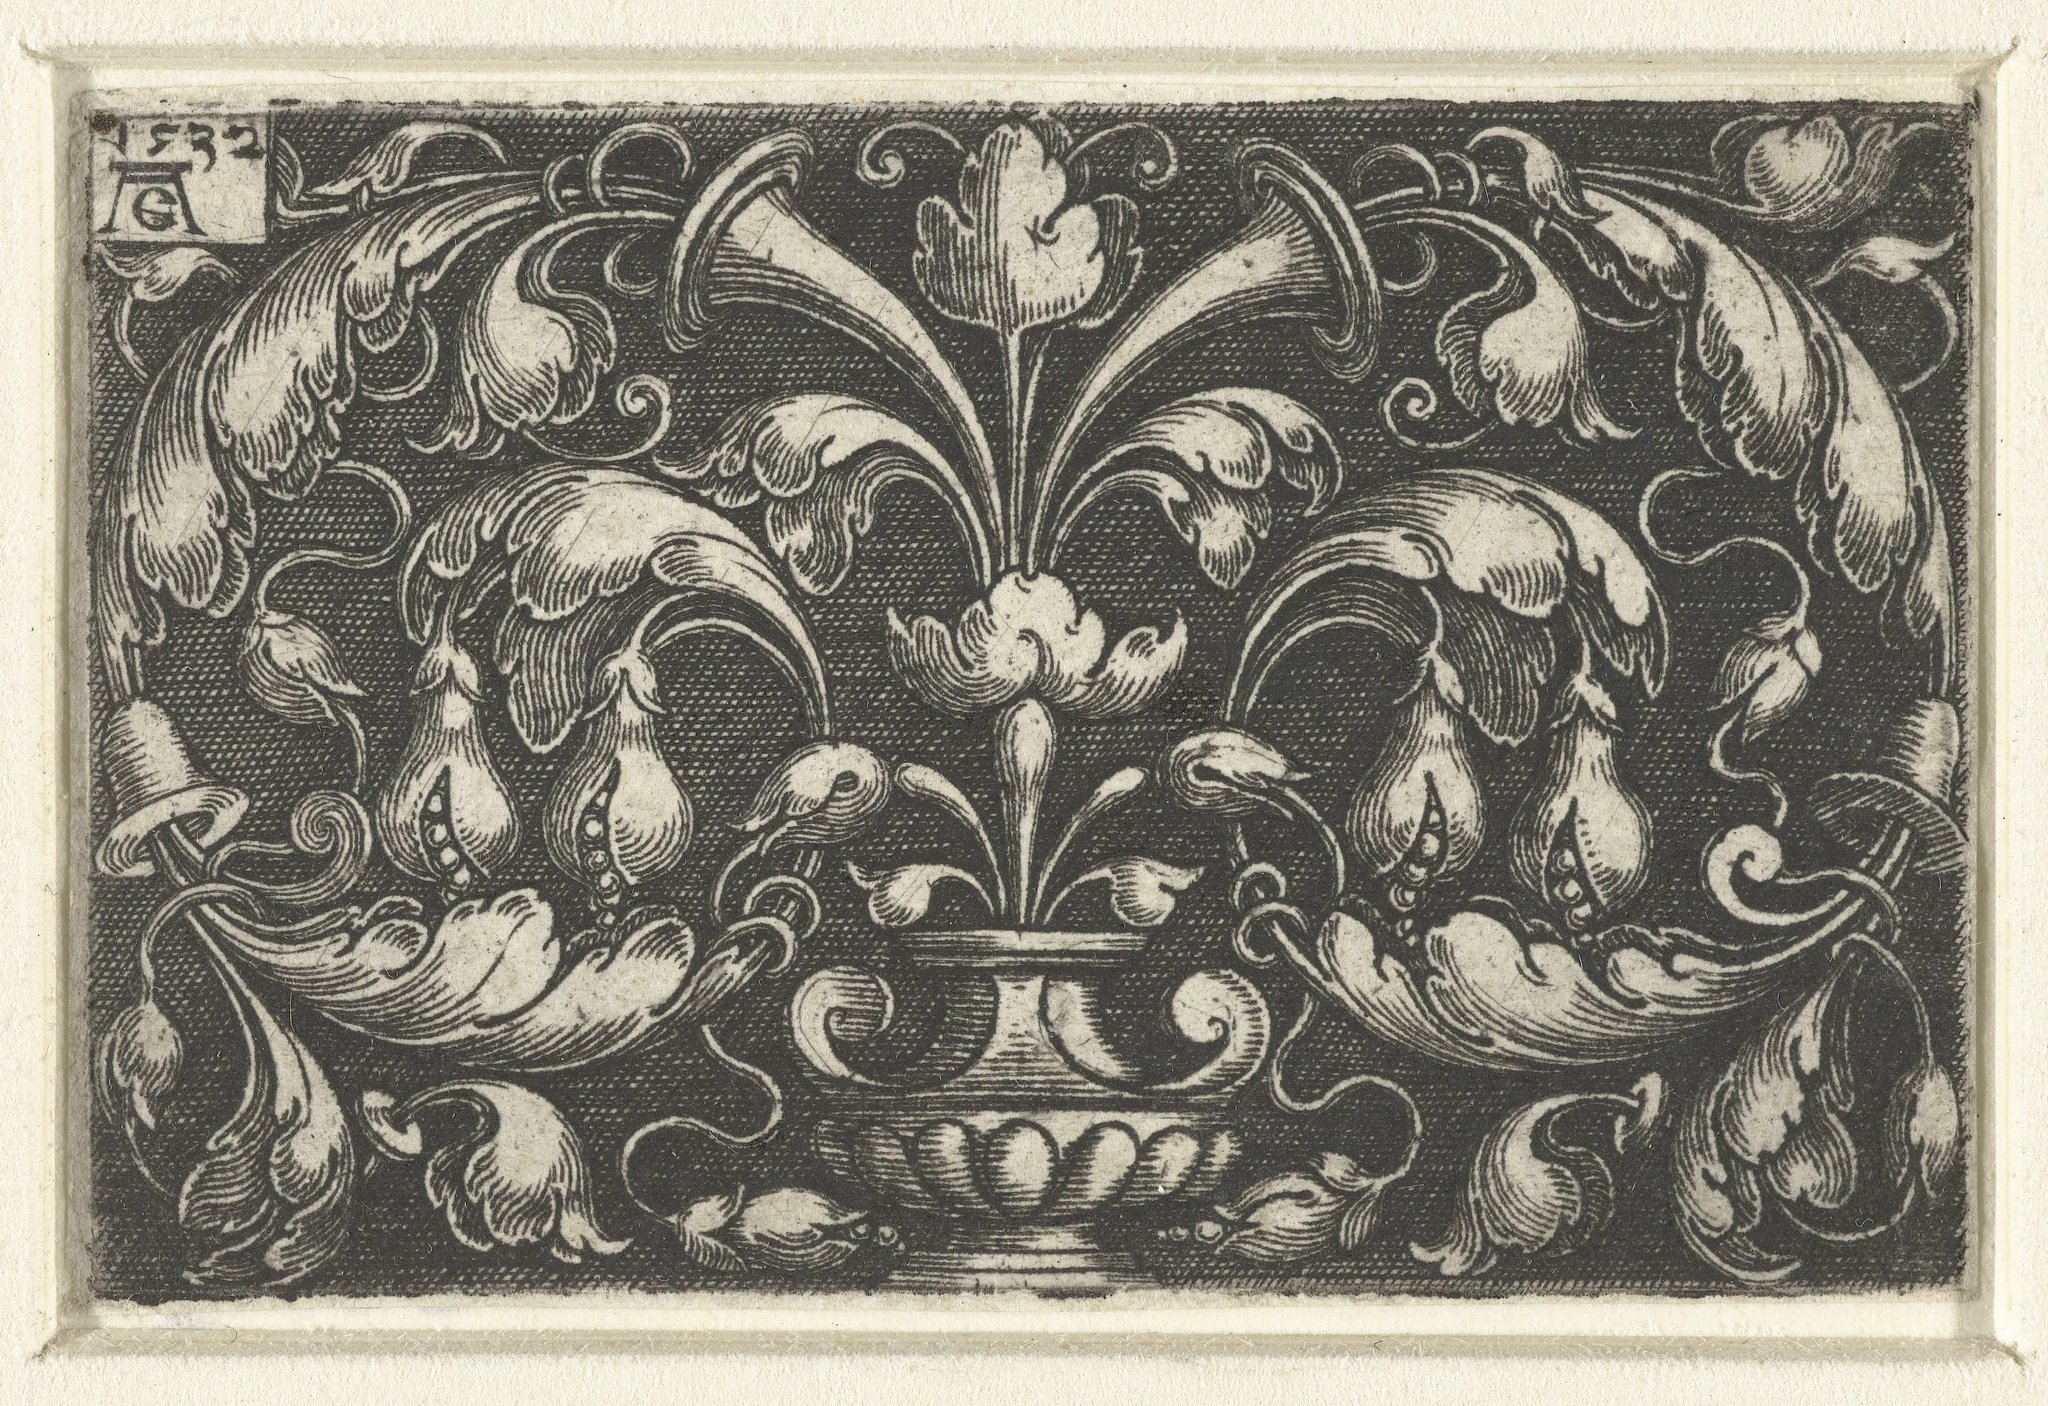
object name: ornament print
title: Vaas waaruit bladranken komen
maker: heinrich aldegrever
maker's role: draughtsman, print maker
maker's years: 1502-1561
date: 1532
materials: paper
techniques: engraving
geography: germany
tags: vase ~ ornament, foliage, tendrils, branches ~ ornament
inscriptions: number: ‘21’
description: Vlakdecoratie met een vaas waaruit bladranken komen die zich in twee voluten symmetrisch over het blad krullen. In het midden van elke voluut hangen twee bloemen.